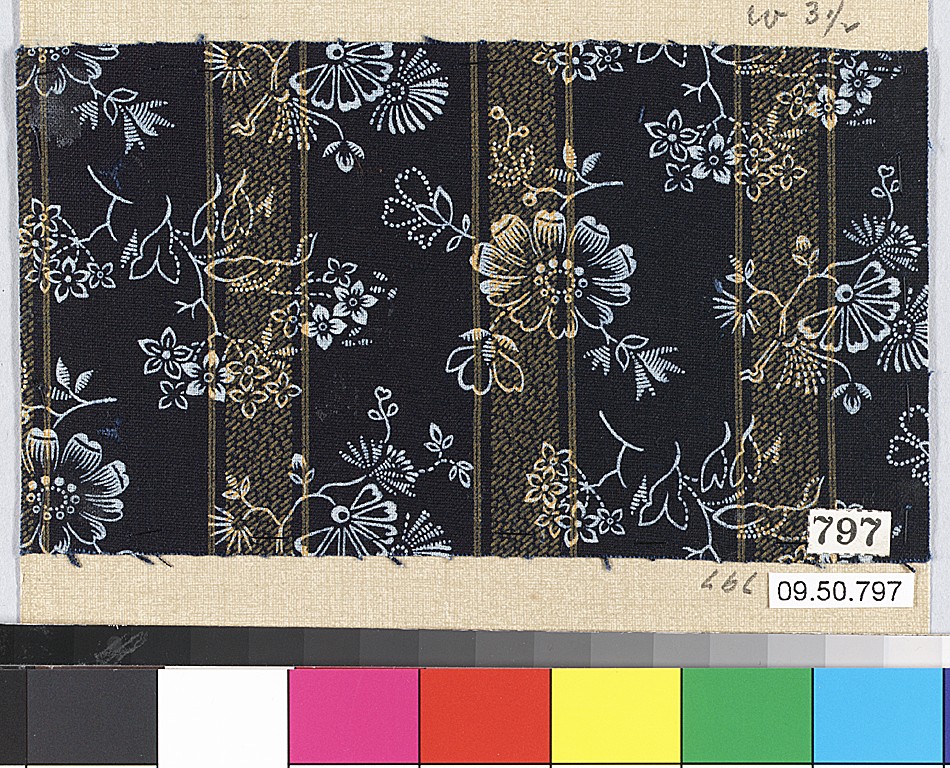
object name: piece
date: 1801-1900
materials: cotton